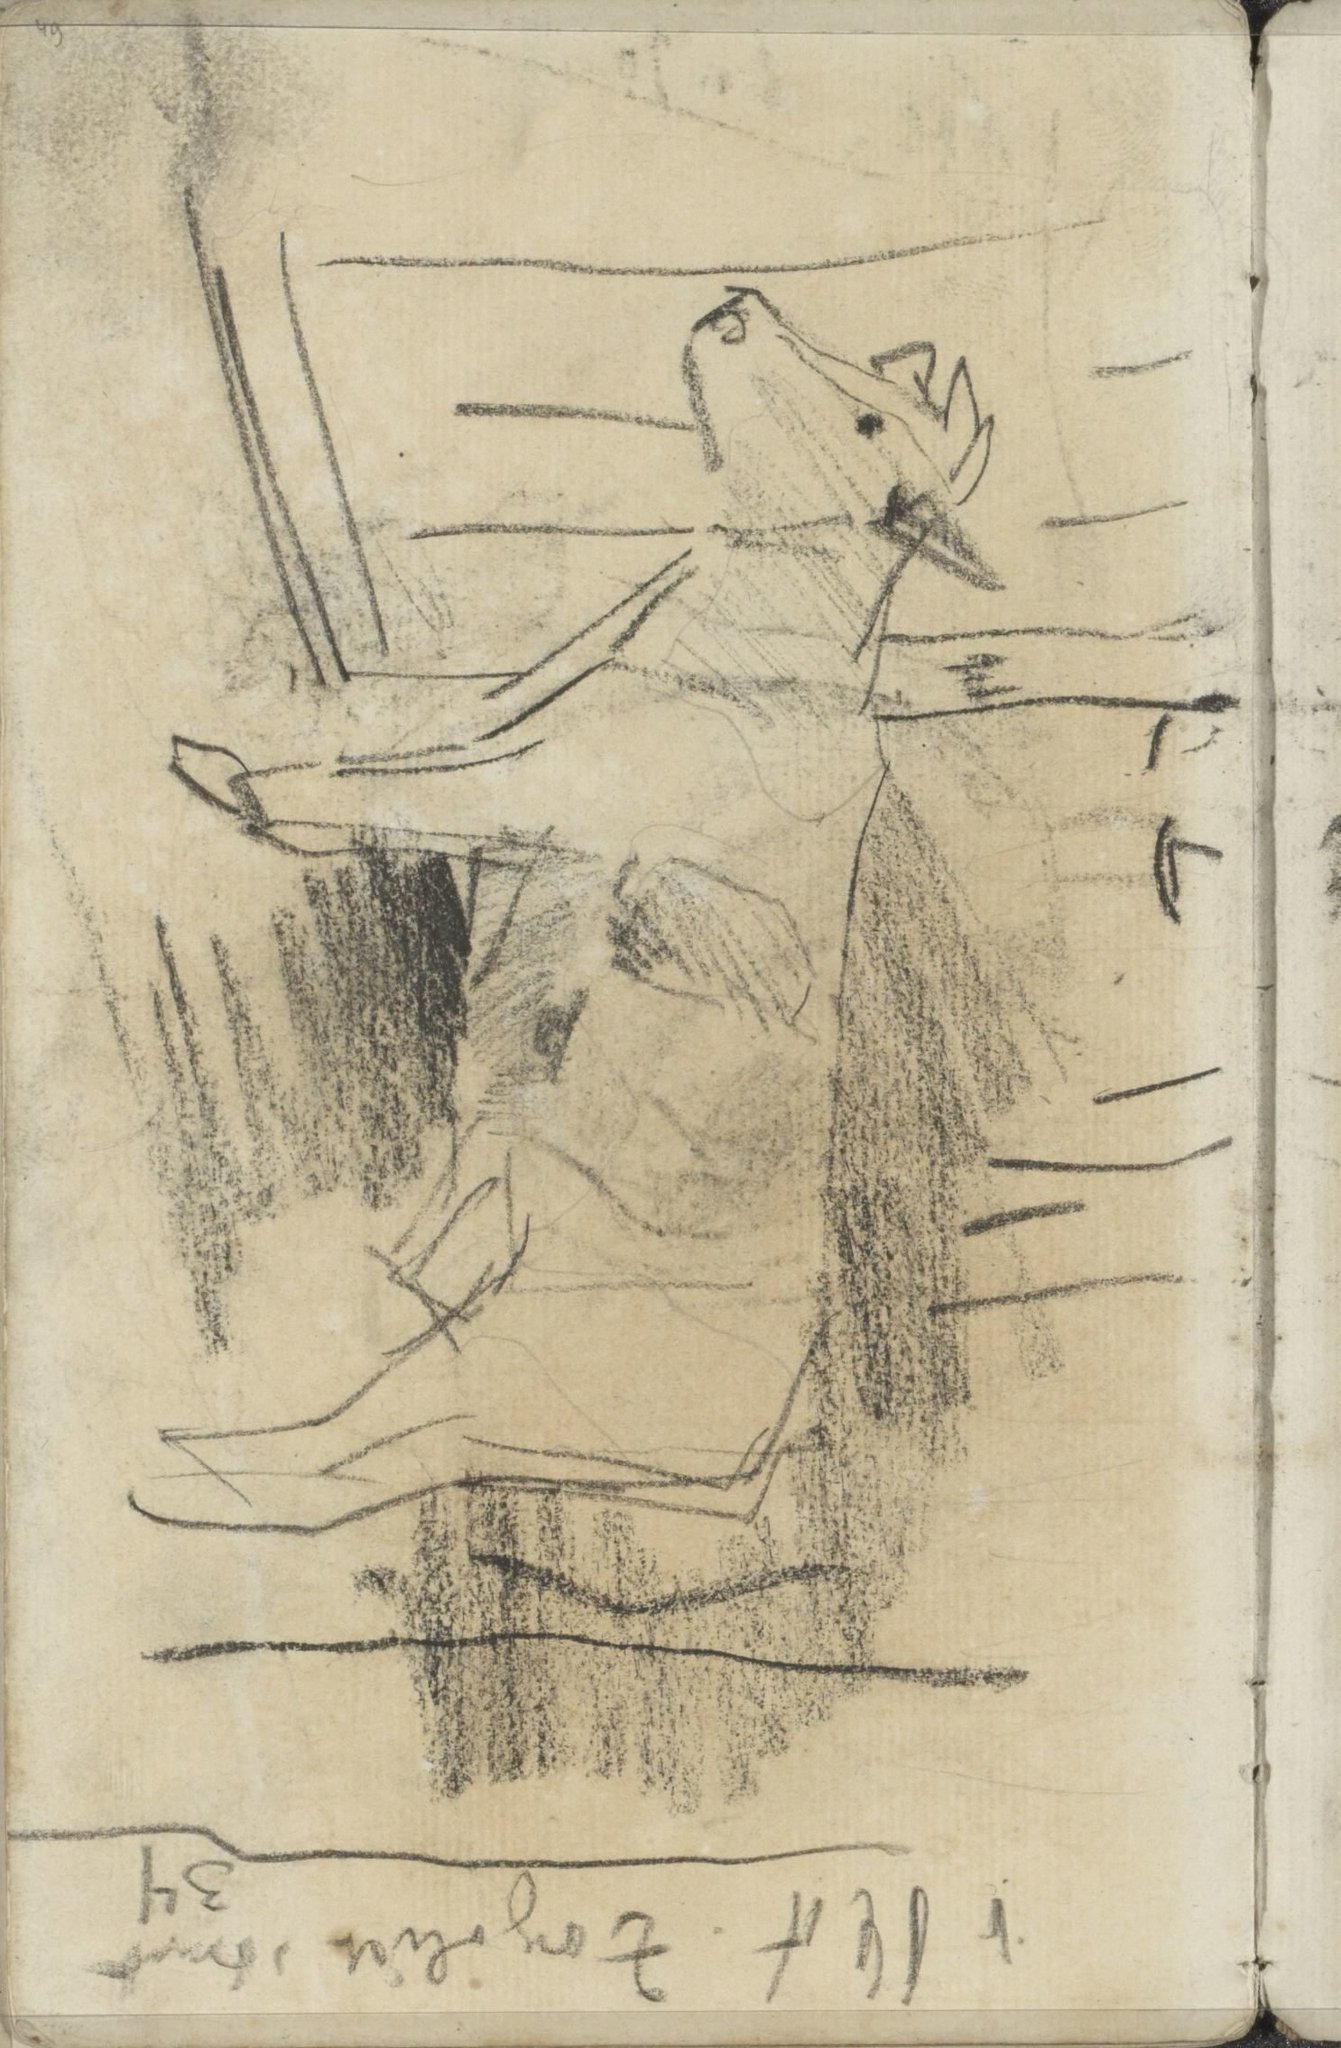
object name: sketchbook leaf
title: Koe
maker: george hendrik breitner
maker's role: draughtsman, painter, print maker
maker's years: 1857-1923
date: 1884-1886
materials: chalk, paper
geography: paris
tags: cow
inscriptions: annotation: ‘[...] Zorgvliet [...]’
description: Pagina 49 uit een schetsboek met 25 bladen.